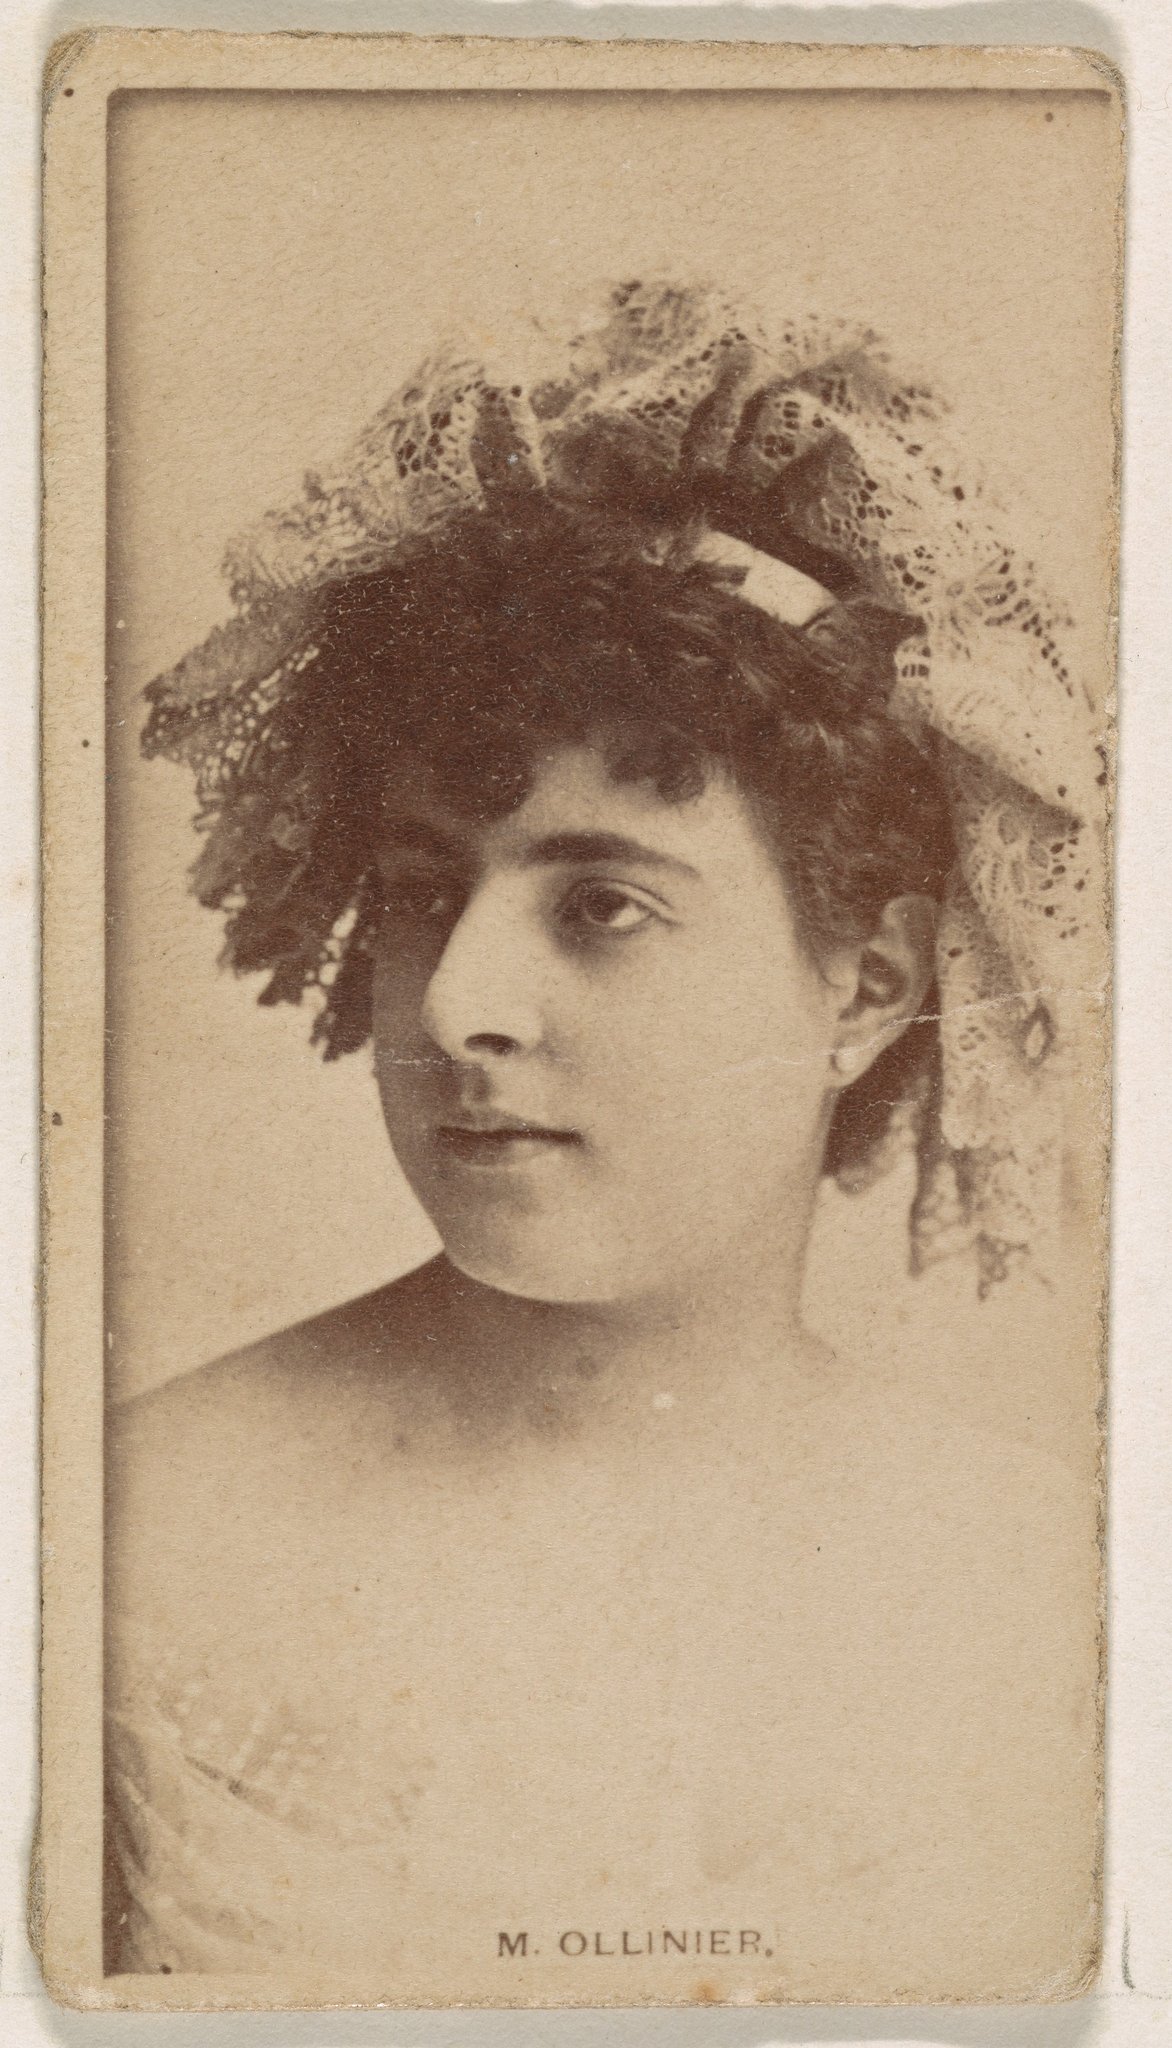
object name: photograph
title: M. Ollinier, from the Actresses series (N245) issued by Kinney Brothers to promote Sweet Caporal Cigarettes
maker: kinney brothers tobacco company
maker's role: publisher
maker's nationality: american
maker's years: 1869-2011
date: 1890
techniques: albumen silver print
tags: portraits,women,actresses